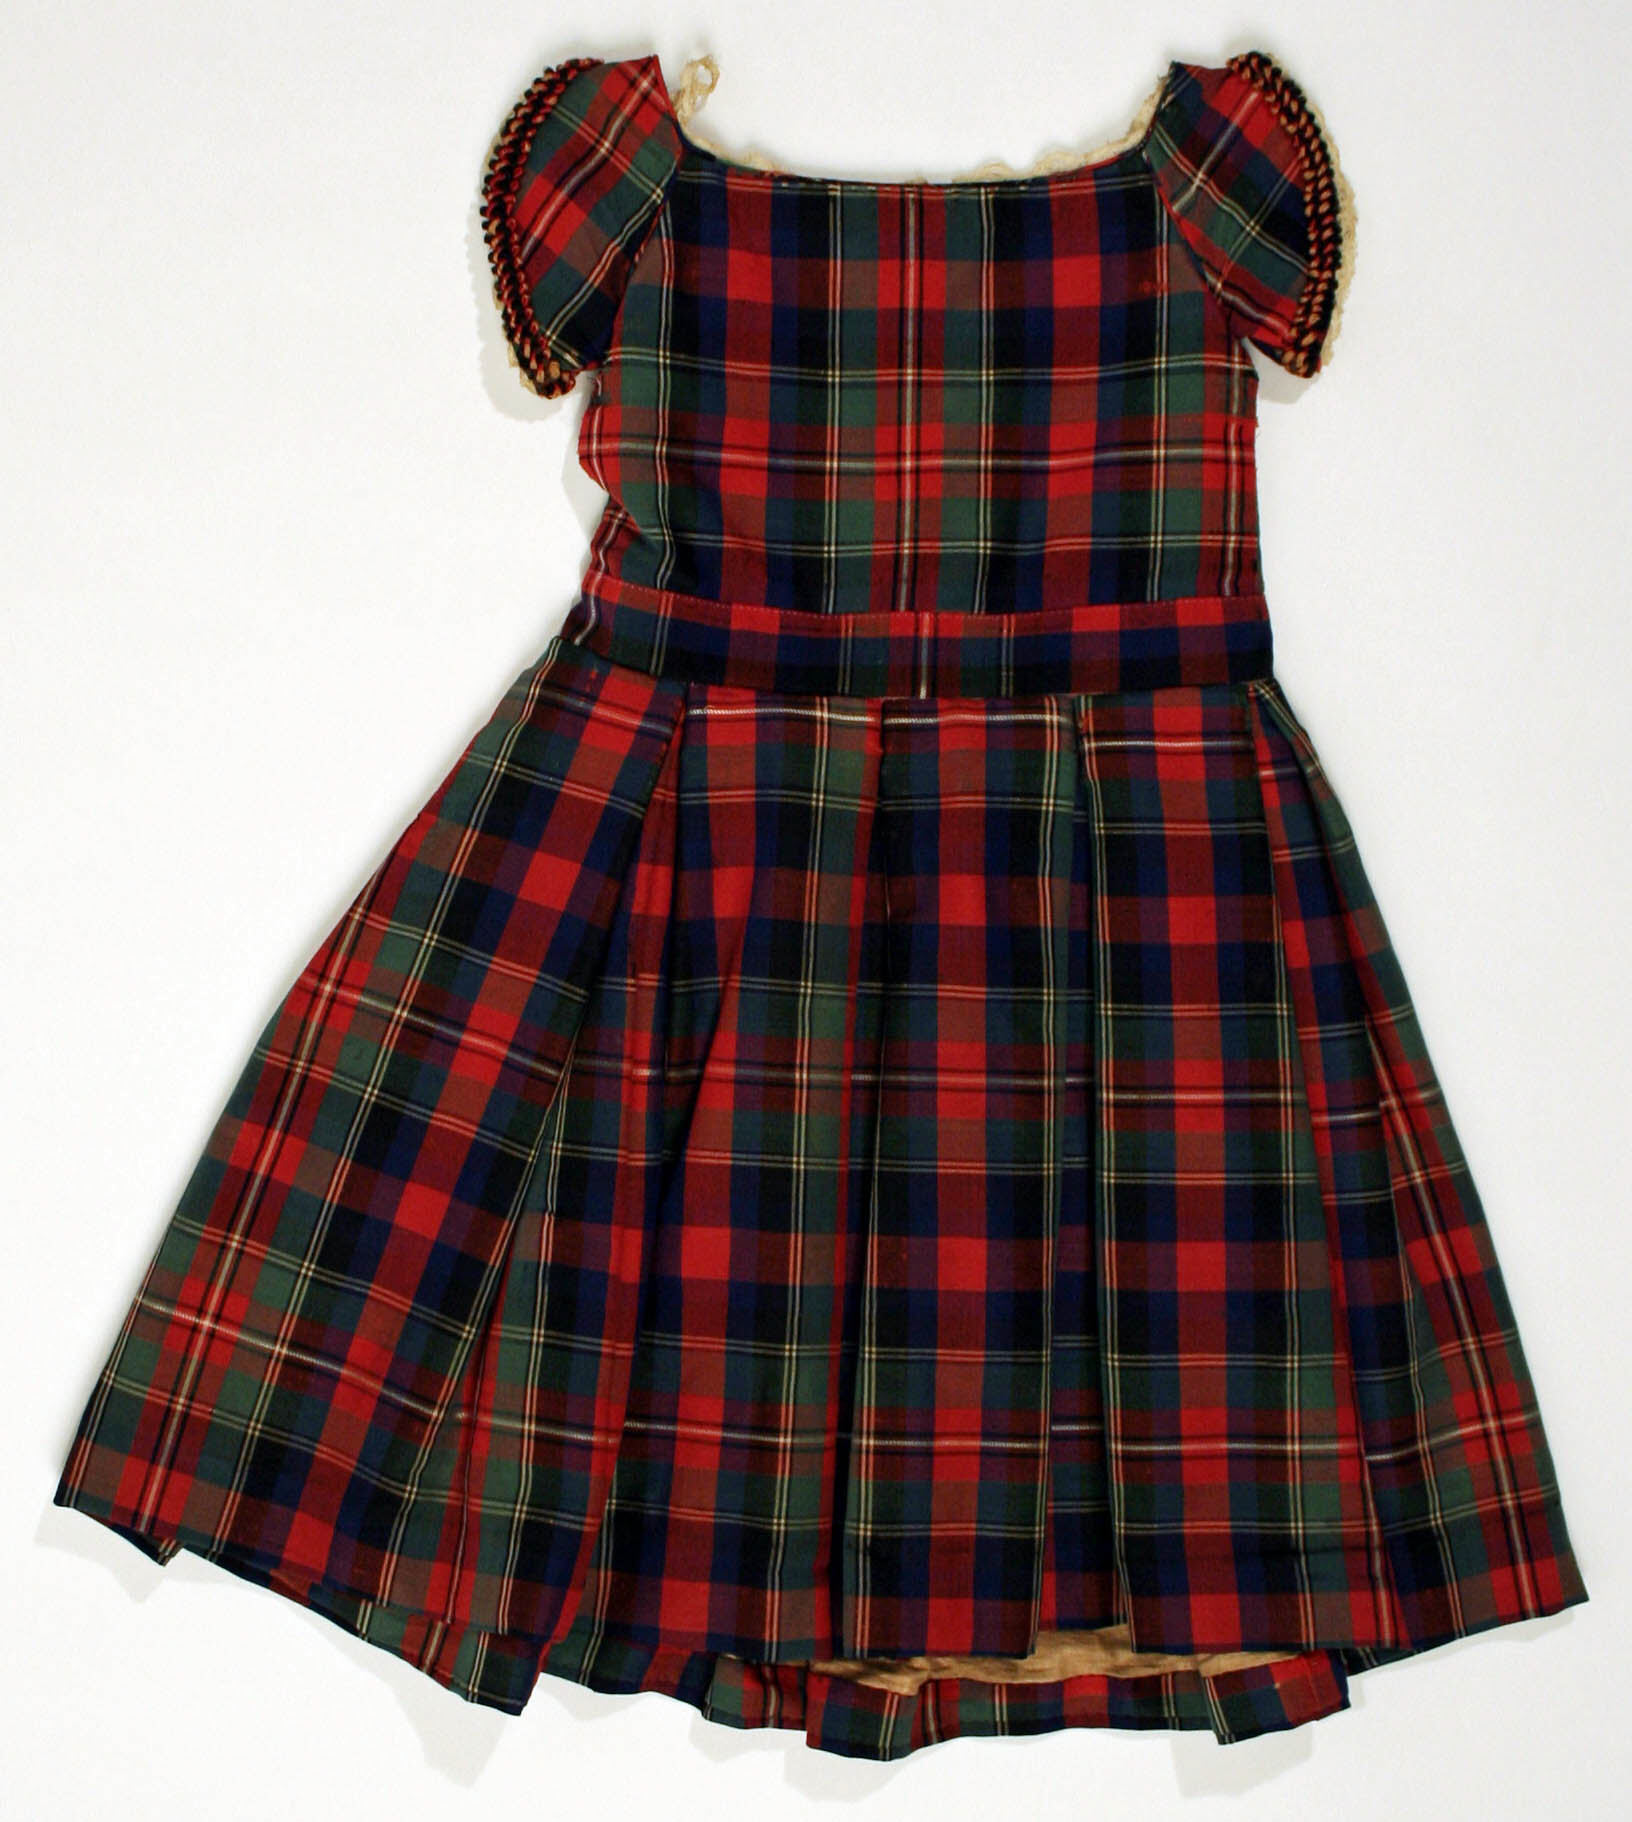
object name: dress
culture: american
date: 1860-1869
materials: silk, wool